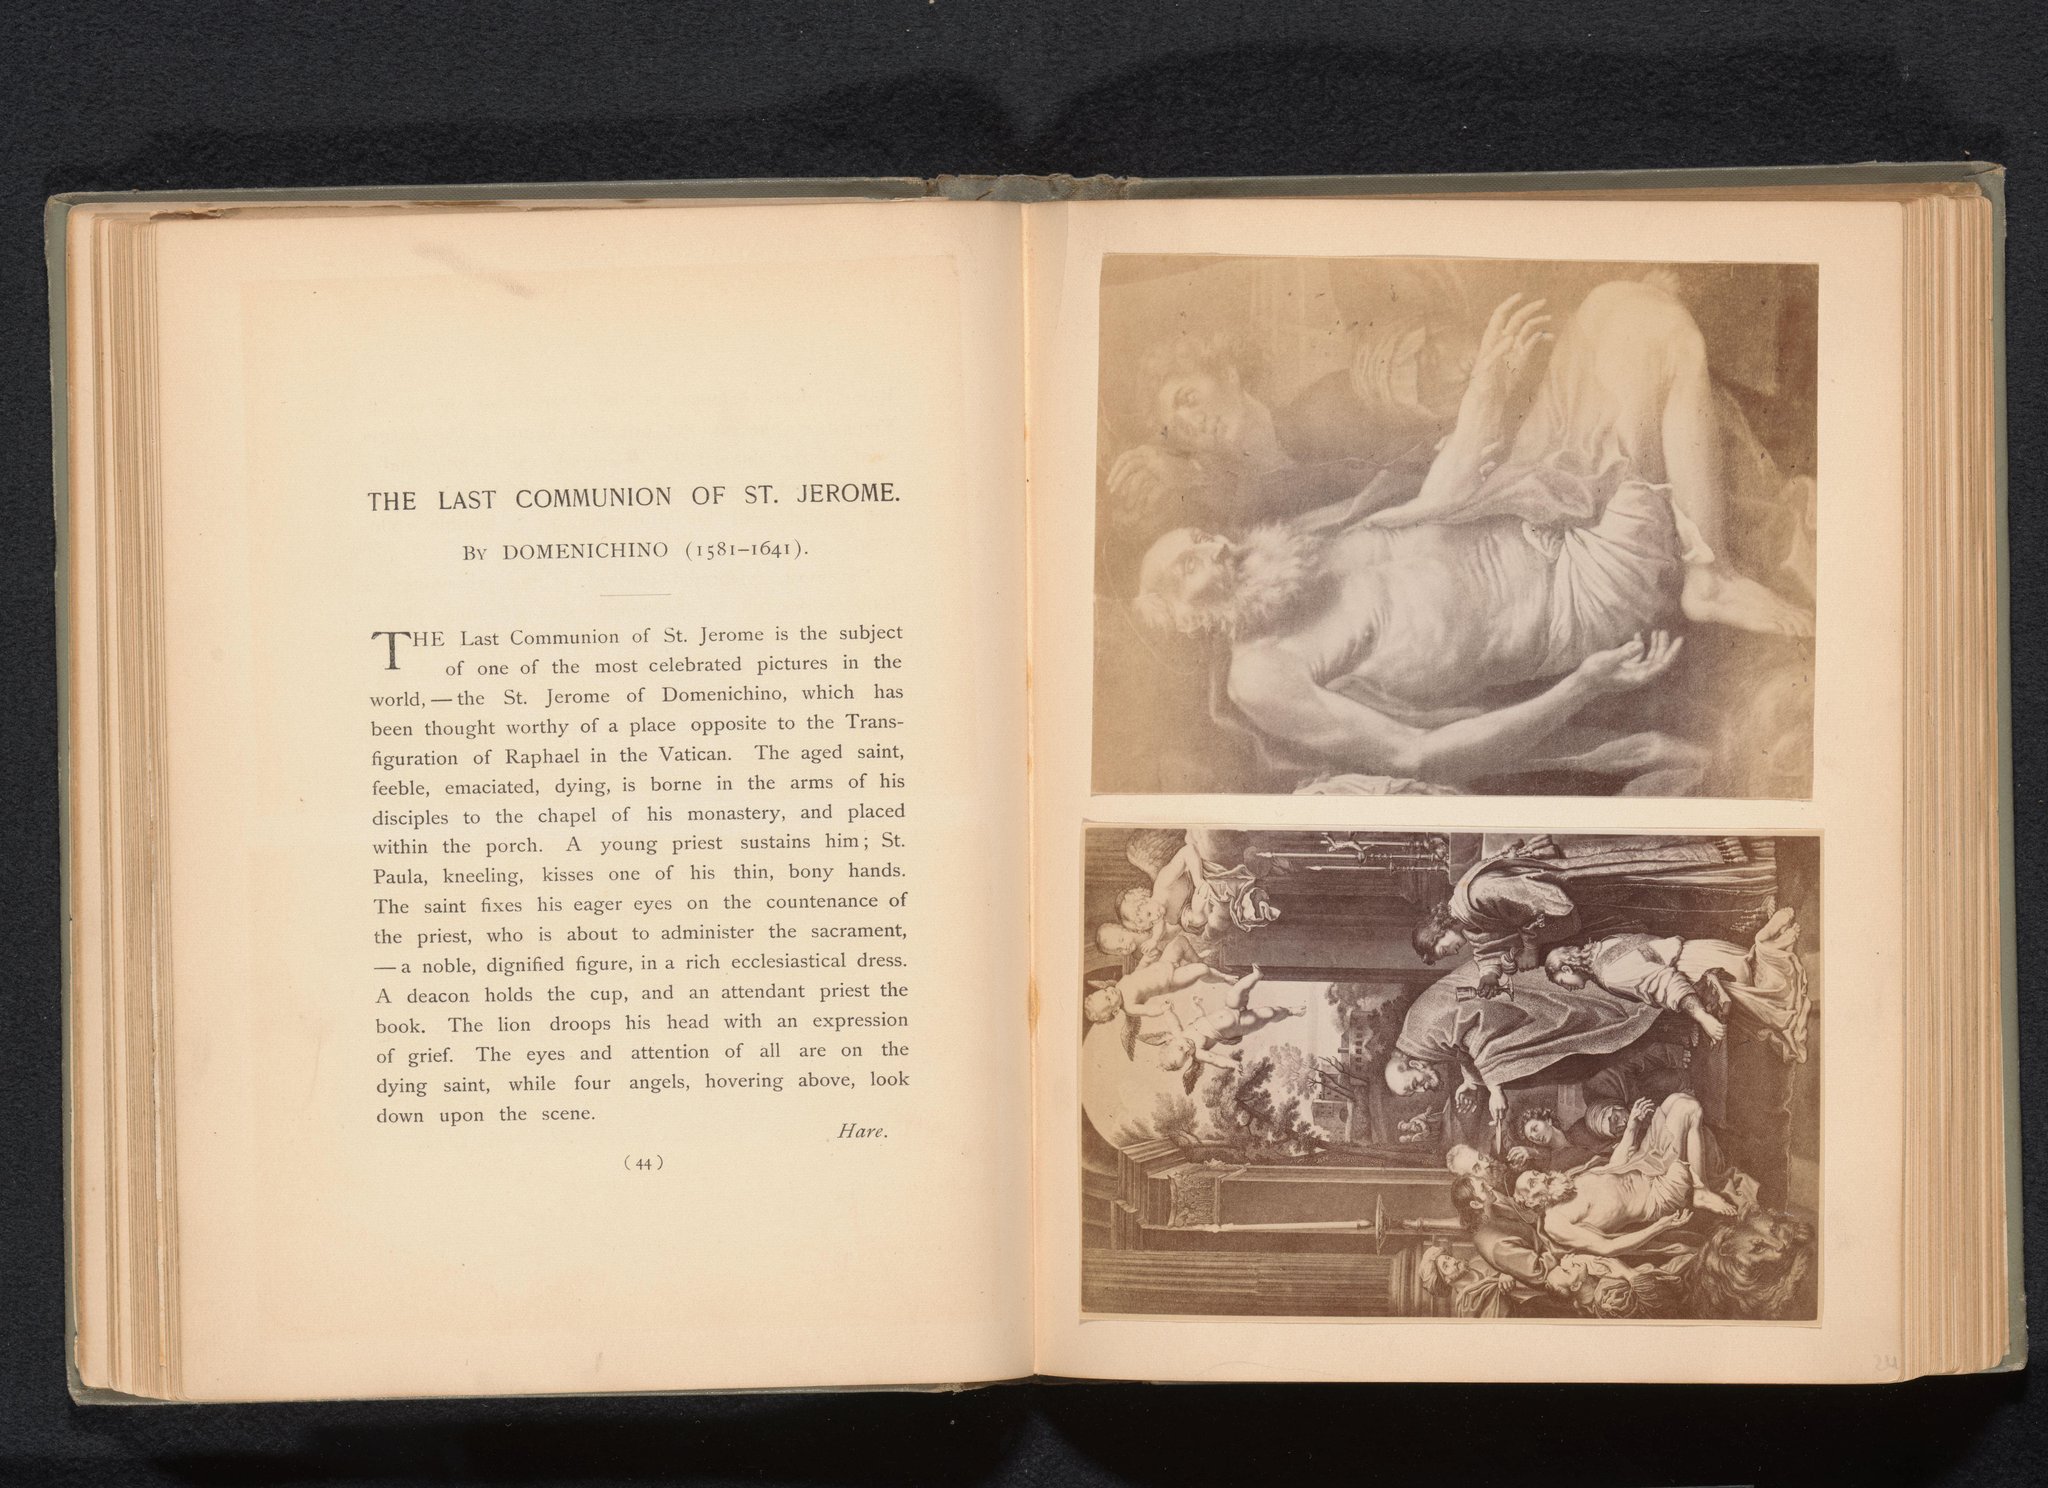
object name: page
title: Twee fotoreproducties van een prent naar een schilderij, voorstellende de laatste communie van de heilige Hiëronymus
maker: Anonymous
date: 1882-1887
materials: photographic support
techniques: albumen print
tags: the last communion of st. jerome: he is attended and supported by younger priests, one of whom is about to administer the sacrament; usually st. paula is present